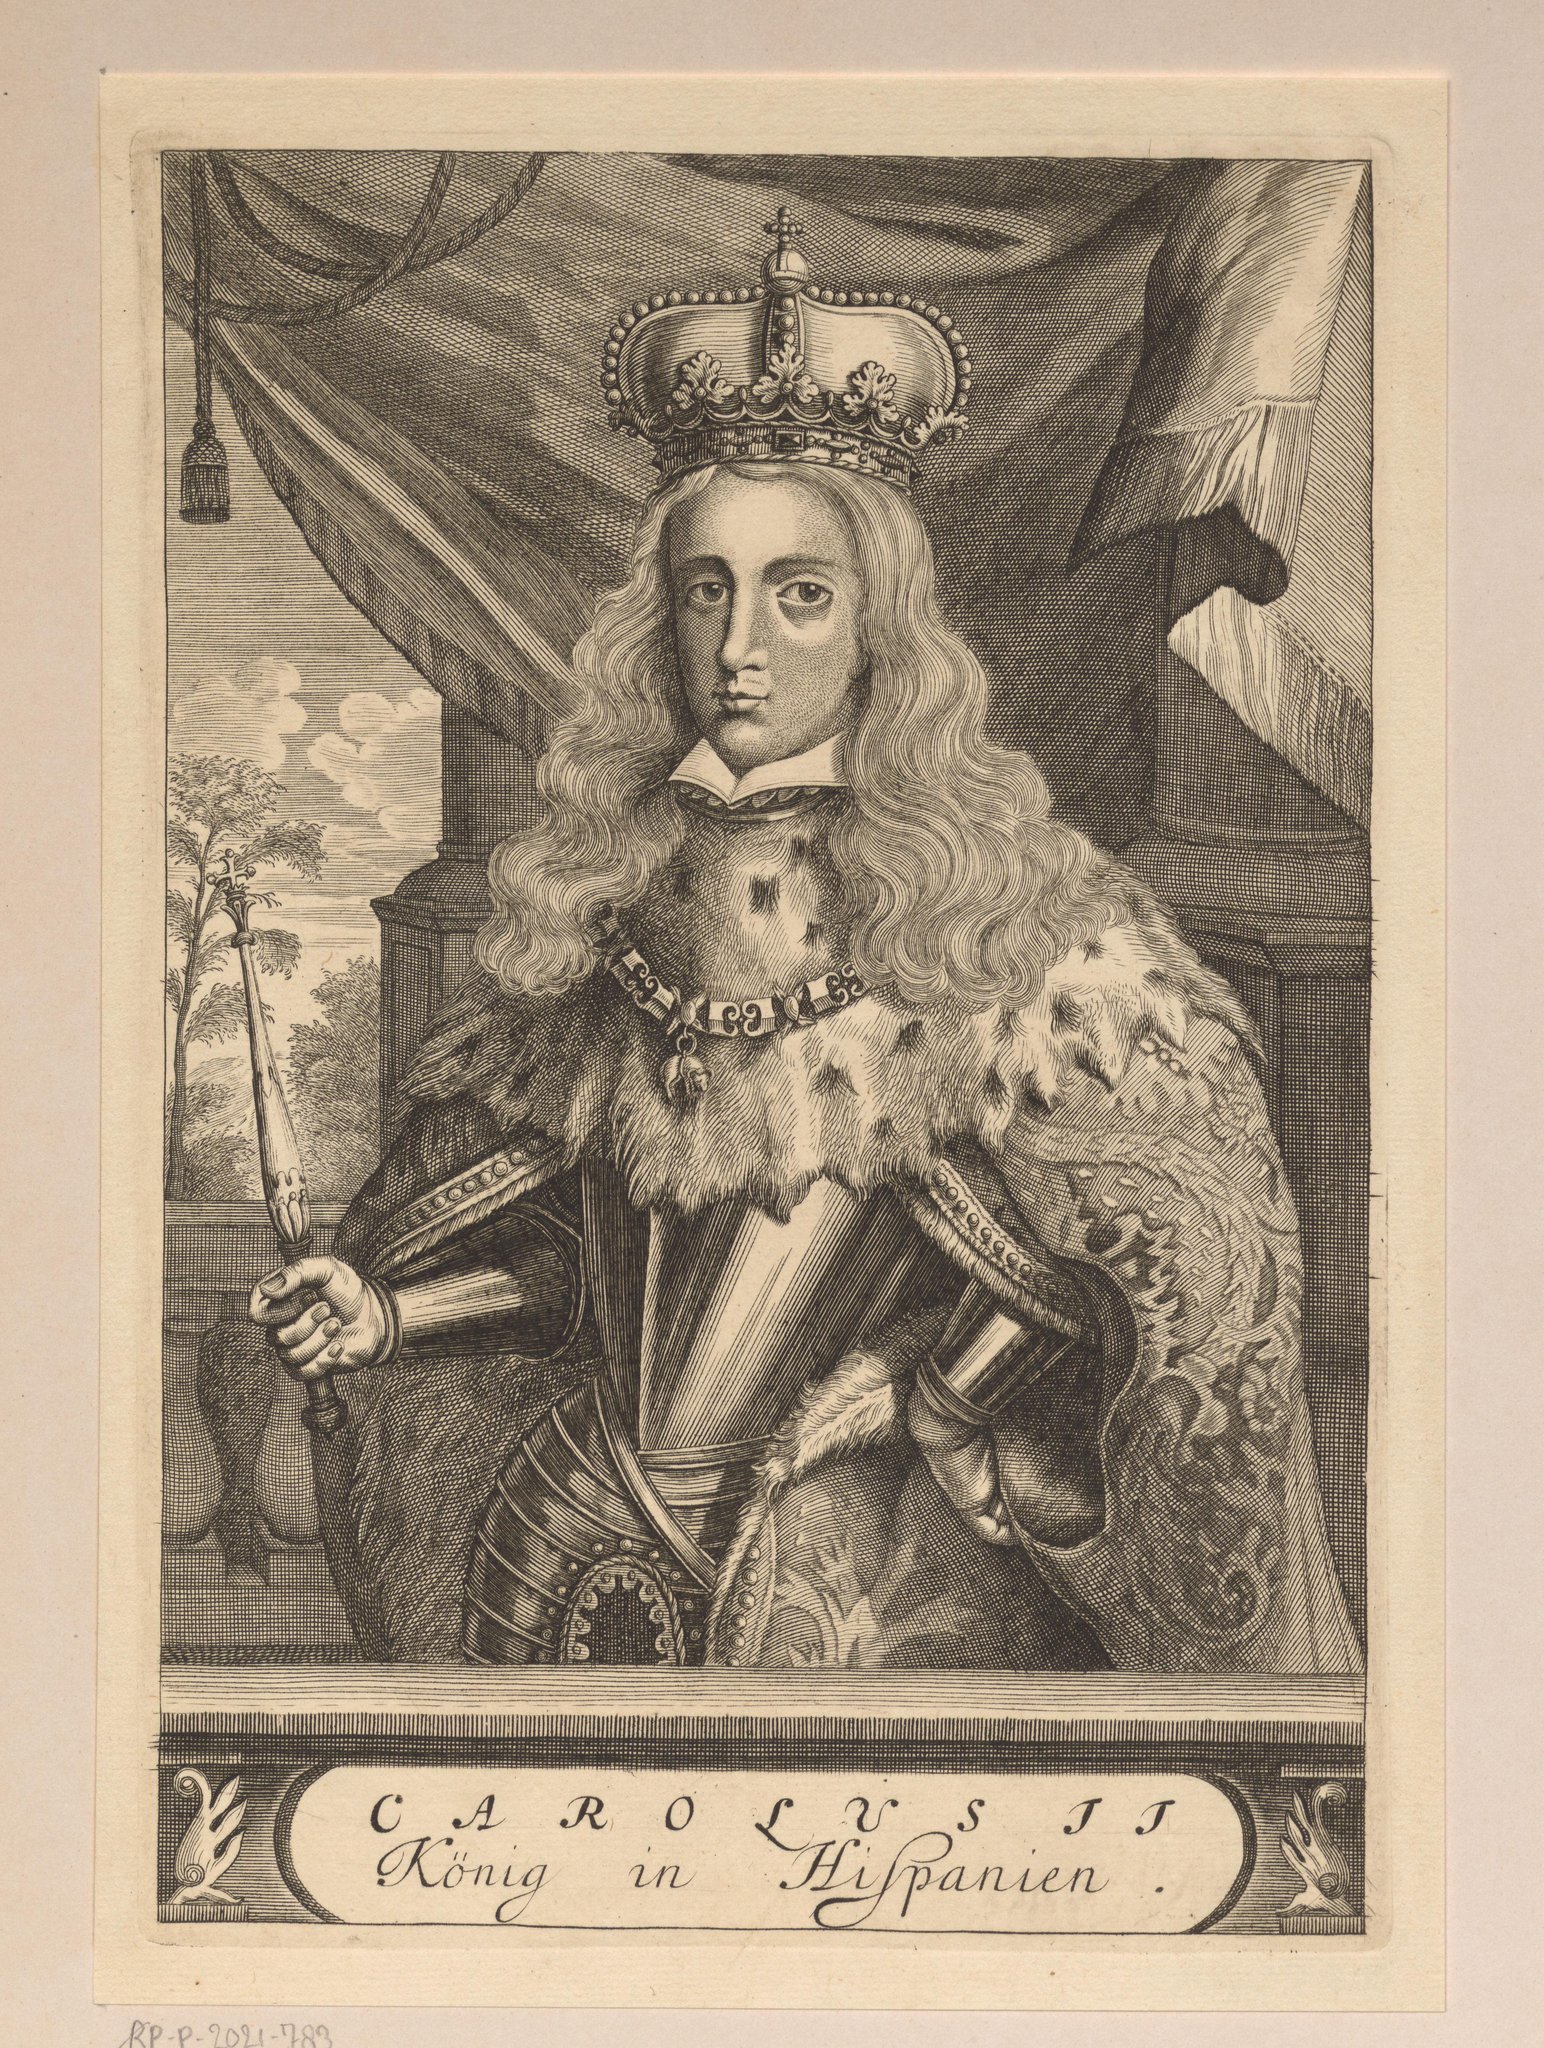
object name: print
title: Portret van Karel II, koning van Spanje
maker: Anonymous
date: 1675-1749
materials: paper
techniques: engraving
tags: karel ii (koning van spanje), historical persons, knighthood order of the golden fleece, king